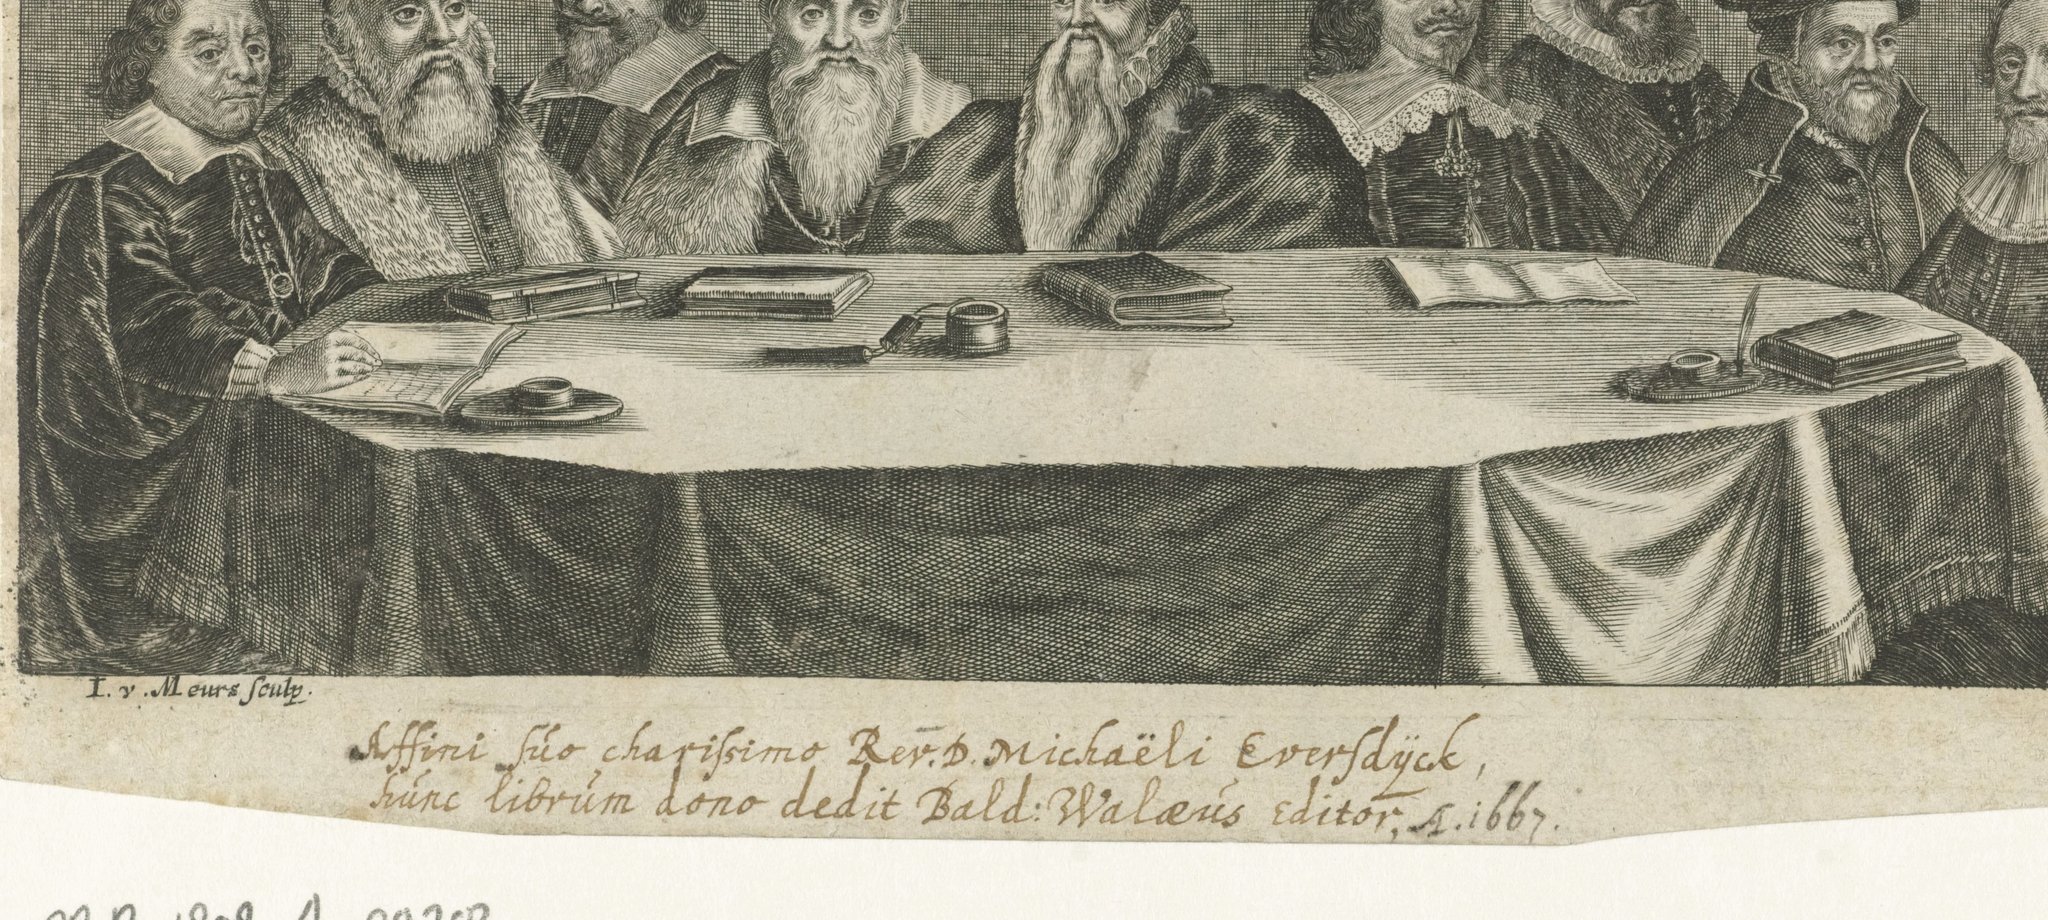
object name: print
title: Geleerden rond een tafel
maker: jacob van meurs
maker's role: draughtsman, print maker, publisher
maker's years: 1619-1680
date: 1653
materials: paper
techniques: engraving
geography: amsterdam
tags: delft, hugo de groot, claudius salmasius, theodorus beza, bruges, ghent, leiden, daniël heinsius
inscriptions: collector's mark: Lugt 964, inscription: ‘Affini suo charissimo ... Walaeus editor, A. 1667.’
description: Fragment van de titelpagina voor: Walaeus, Balduinus. Novi Testamenti libri historici, Græc. & Lat. Perpetuo commentario ex antiquitate, historiis, philologia, illustrati. Leiden: Adriaen Wijngaerden, 1653 en Amsterdam: Johannes van Ravesteyn, 1662.